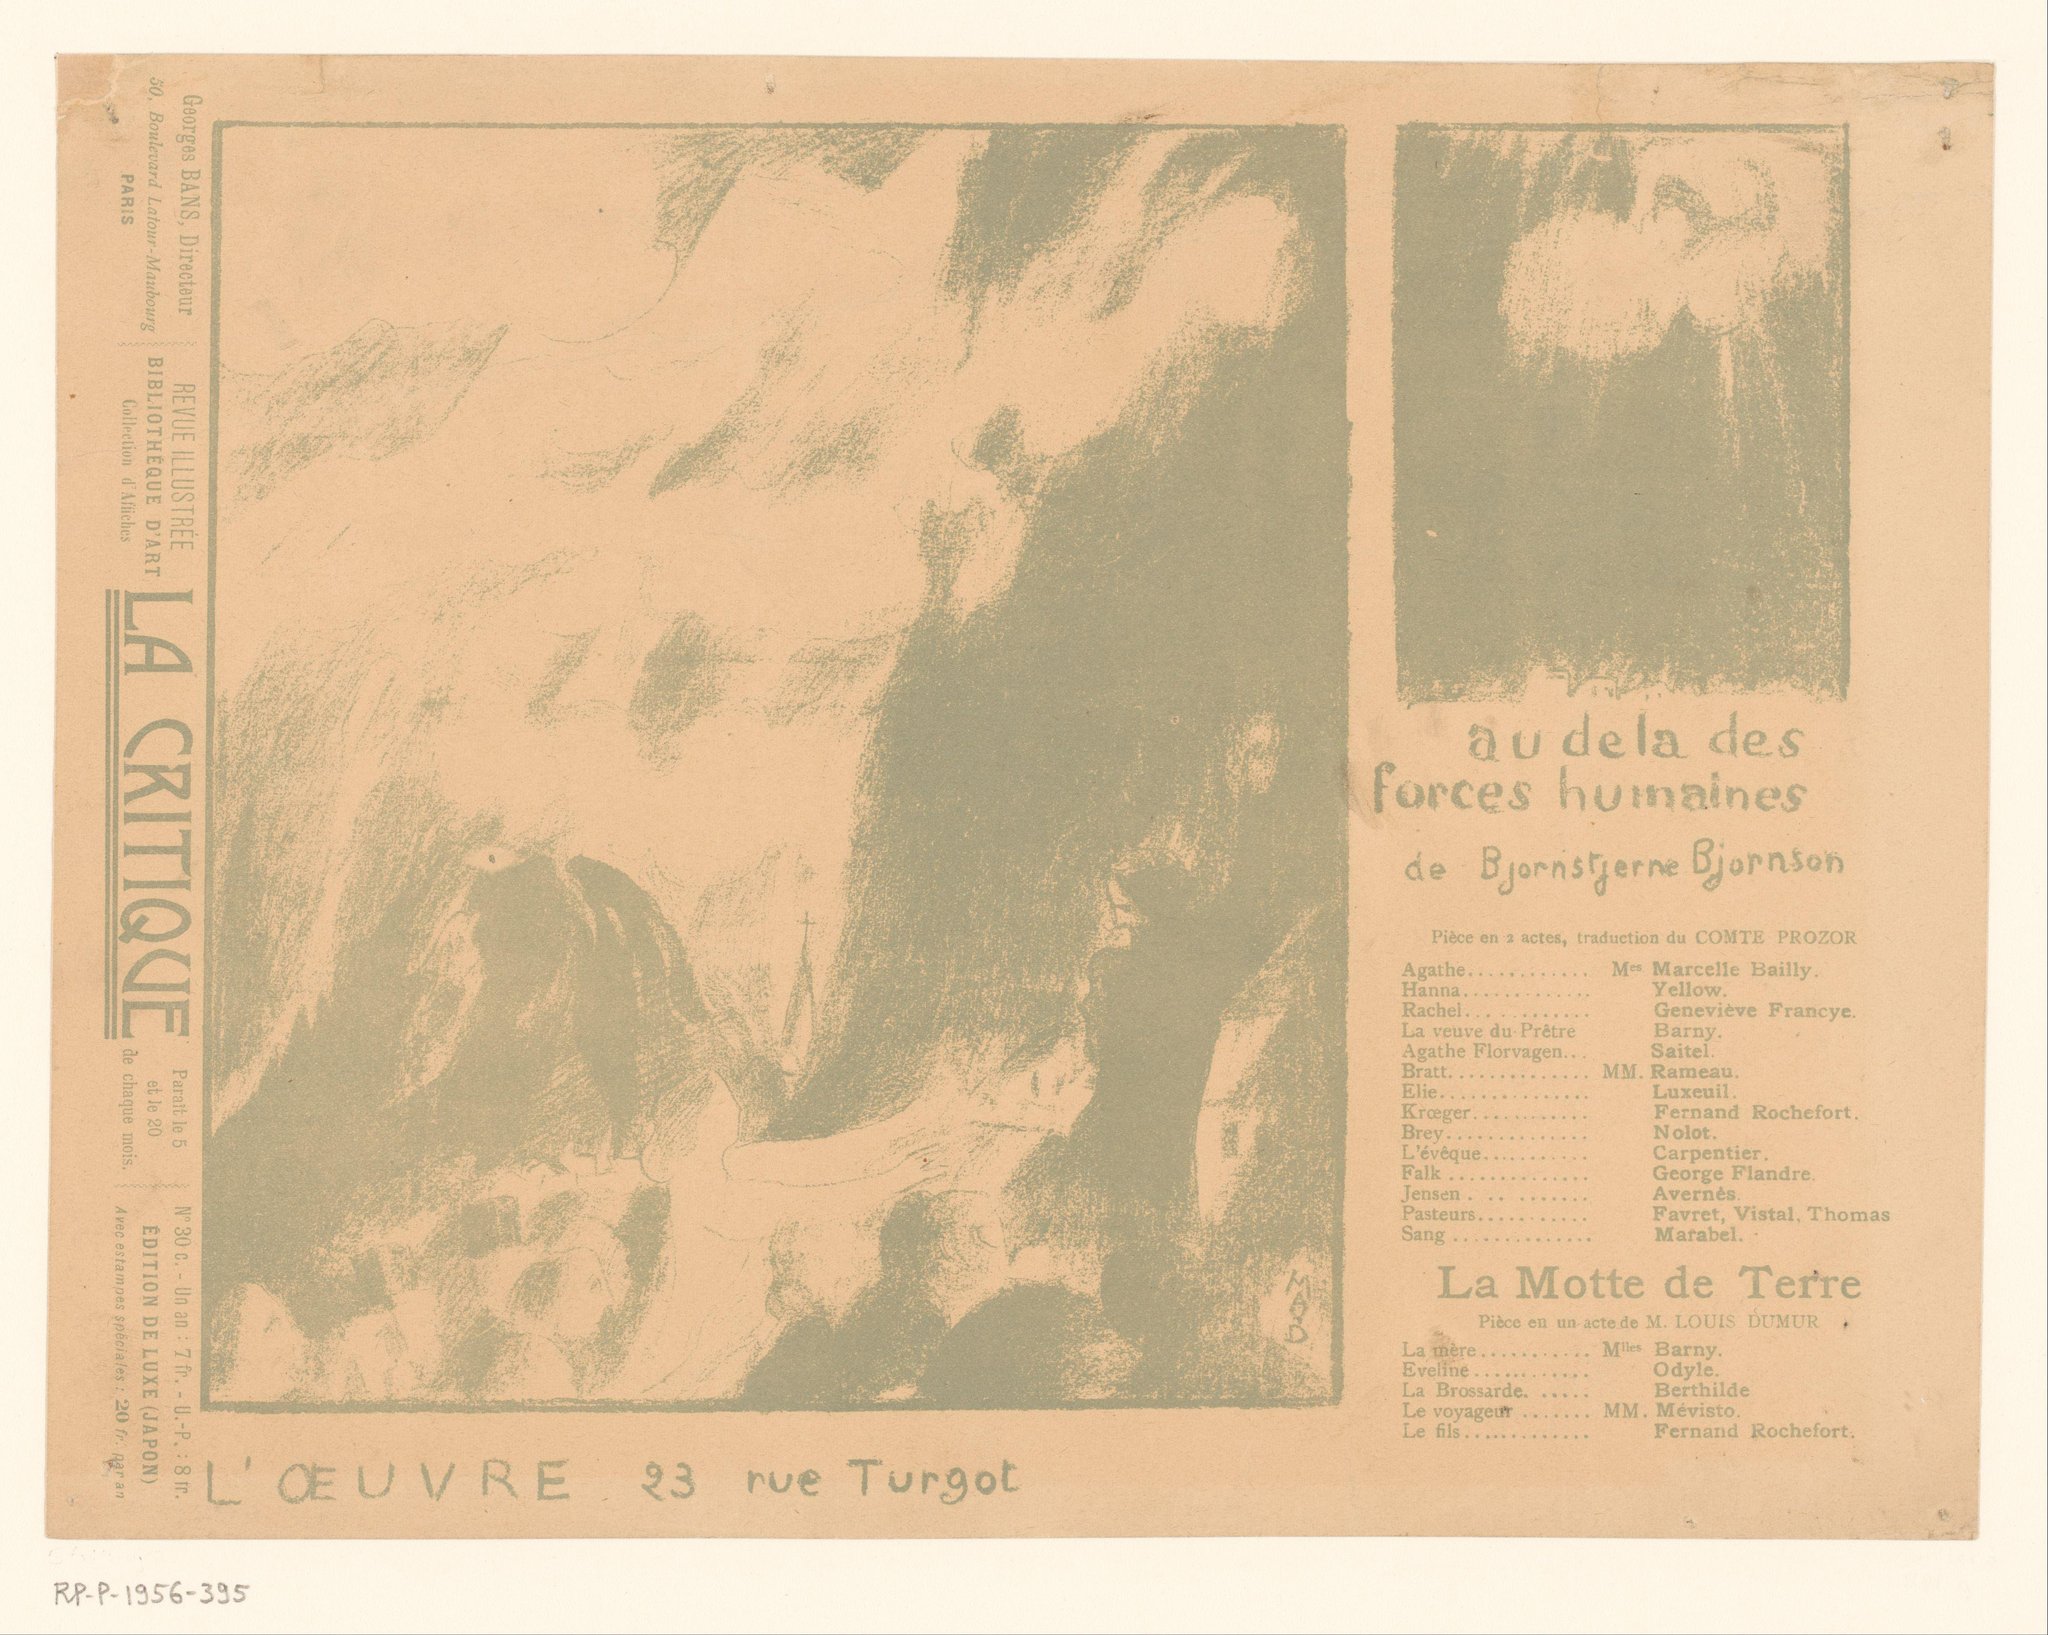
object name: poster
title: Affiche voor het toneelstuk Au-delà des forces humaines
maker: maurice denis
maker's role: print maker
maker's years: 1870-1943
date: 1897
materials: paper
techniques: lithograph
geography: paris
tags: ecstasy, spiritual exaltation, rapture, poster, arm stretched forward, parts of church exterior and annexes: tower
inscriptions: collector's mark: Lugt 2228a